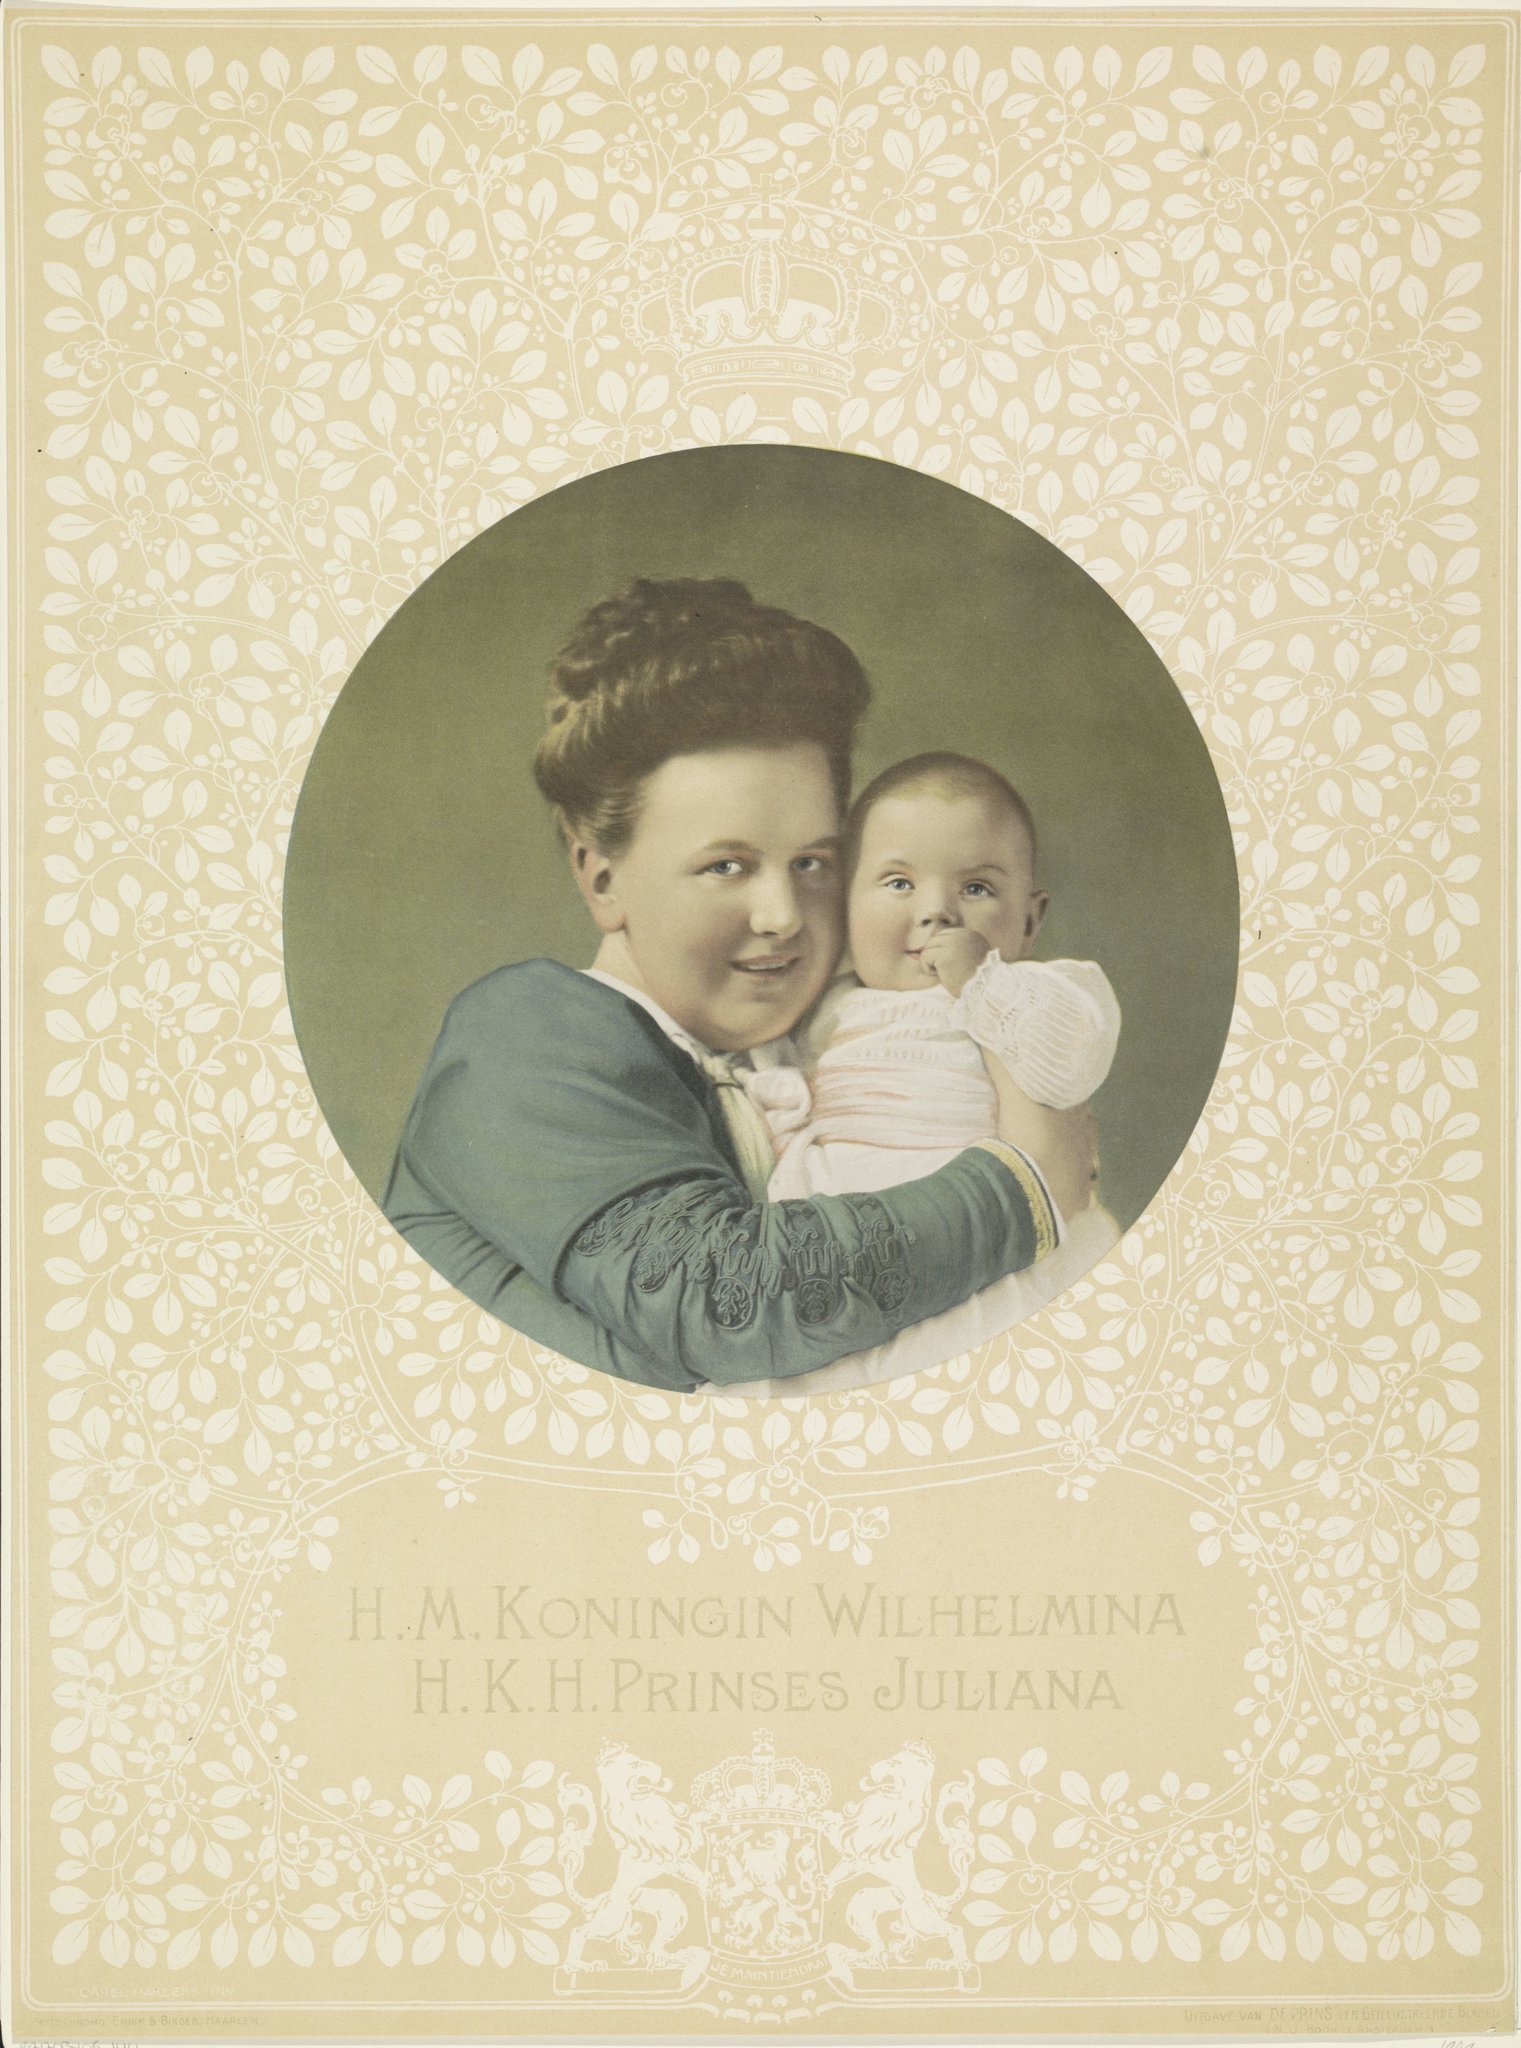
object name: photomechanical print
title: Portret van Wilhelmina, koningin der Nederlanden, en Juliana, koningin der Nederlanden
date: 1909-1911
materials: paper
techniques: photograph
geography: amsterdam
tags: print maker, wilhelmina of the netherlands, juliana of the netherlands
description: Portret van Wilhelmina en Juliana in een cirkel met eronder hun namen en titels. Daar omheen takken van een oranjeboom met bladeren en vruchten. Midden boven een kroon. Midden onder een wapen met een kroon en twee leeuwen.